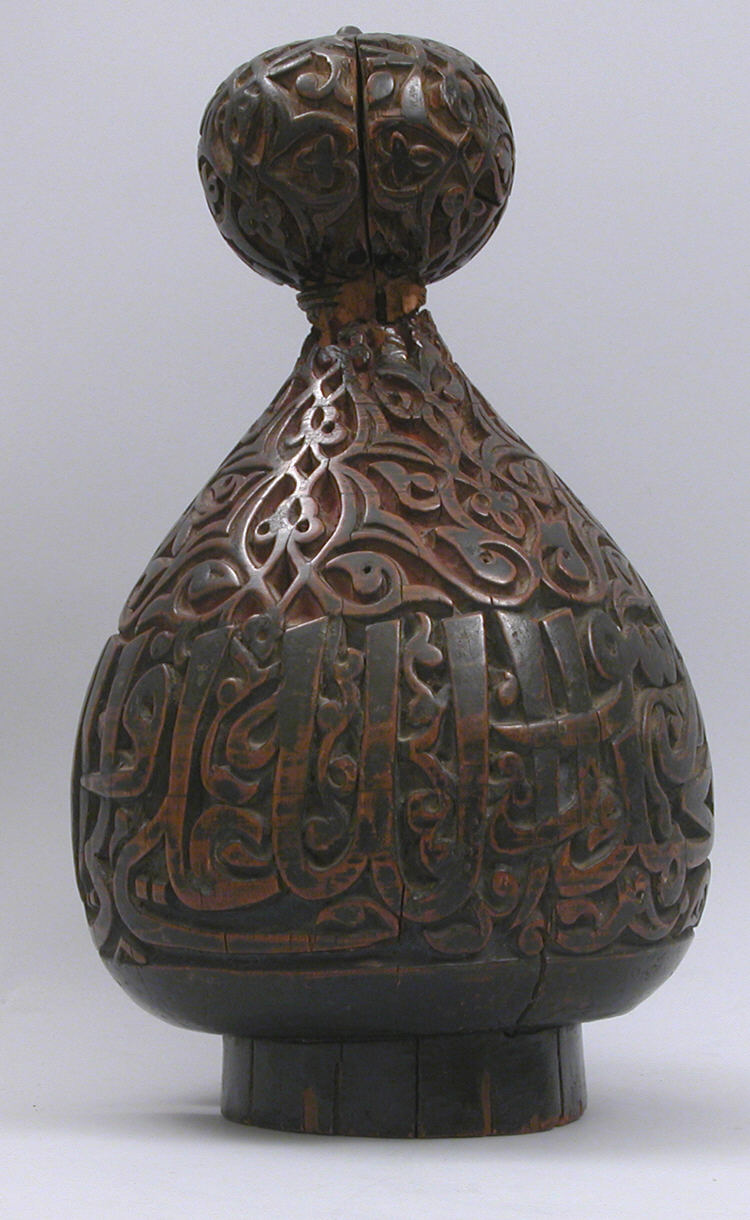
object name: finial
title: Finial, Possibly from a Cenotaph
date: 1367-1600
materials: paint, wood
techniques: carving, gilding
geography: turkey or iran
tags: arabic